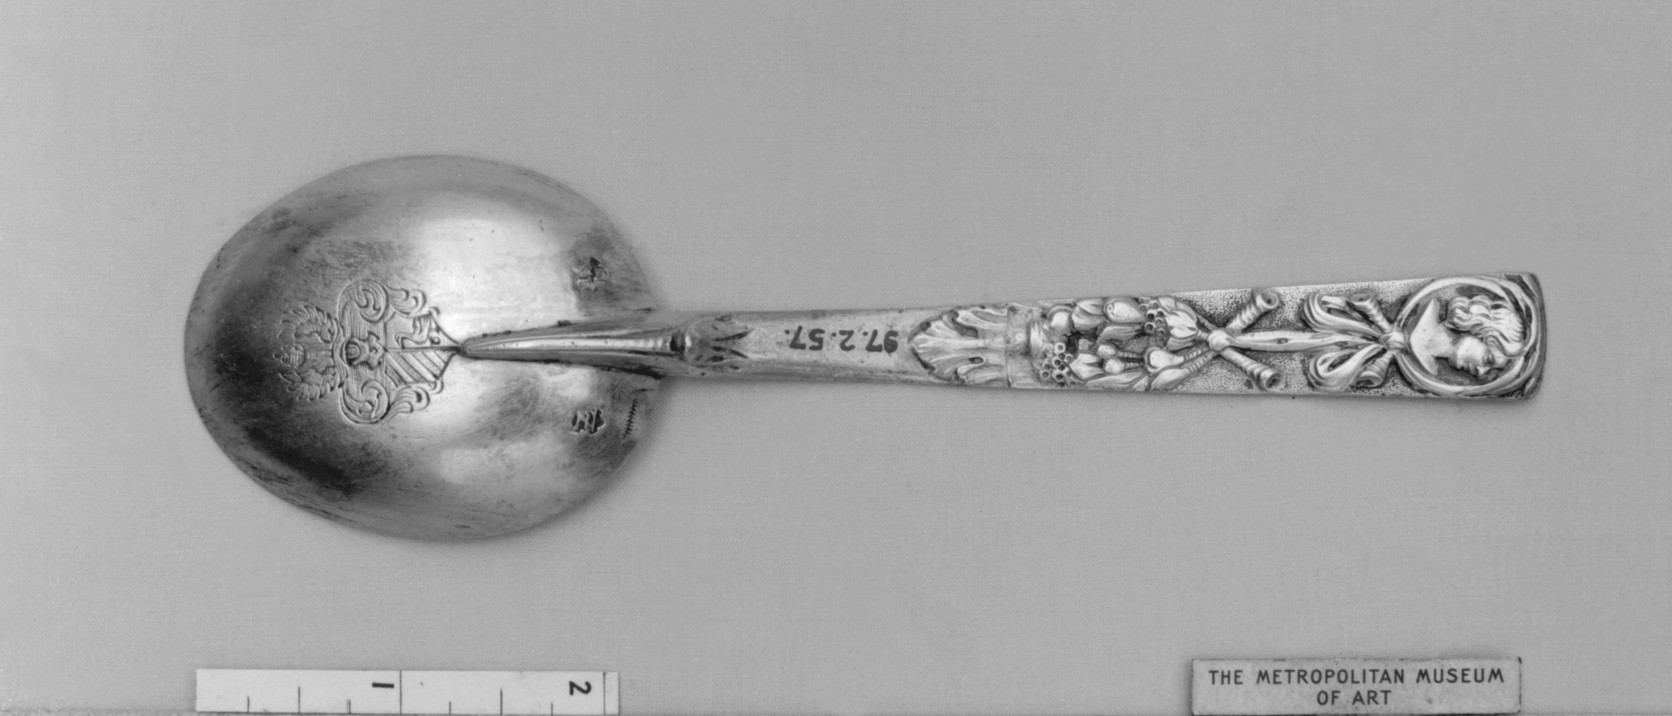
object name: spoon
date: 1701-1733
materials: silver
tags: women,coat of arms